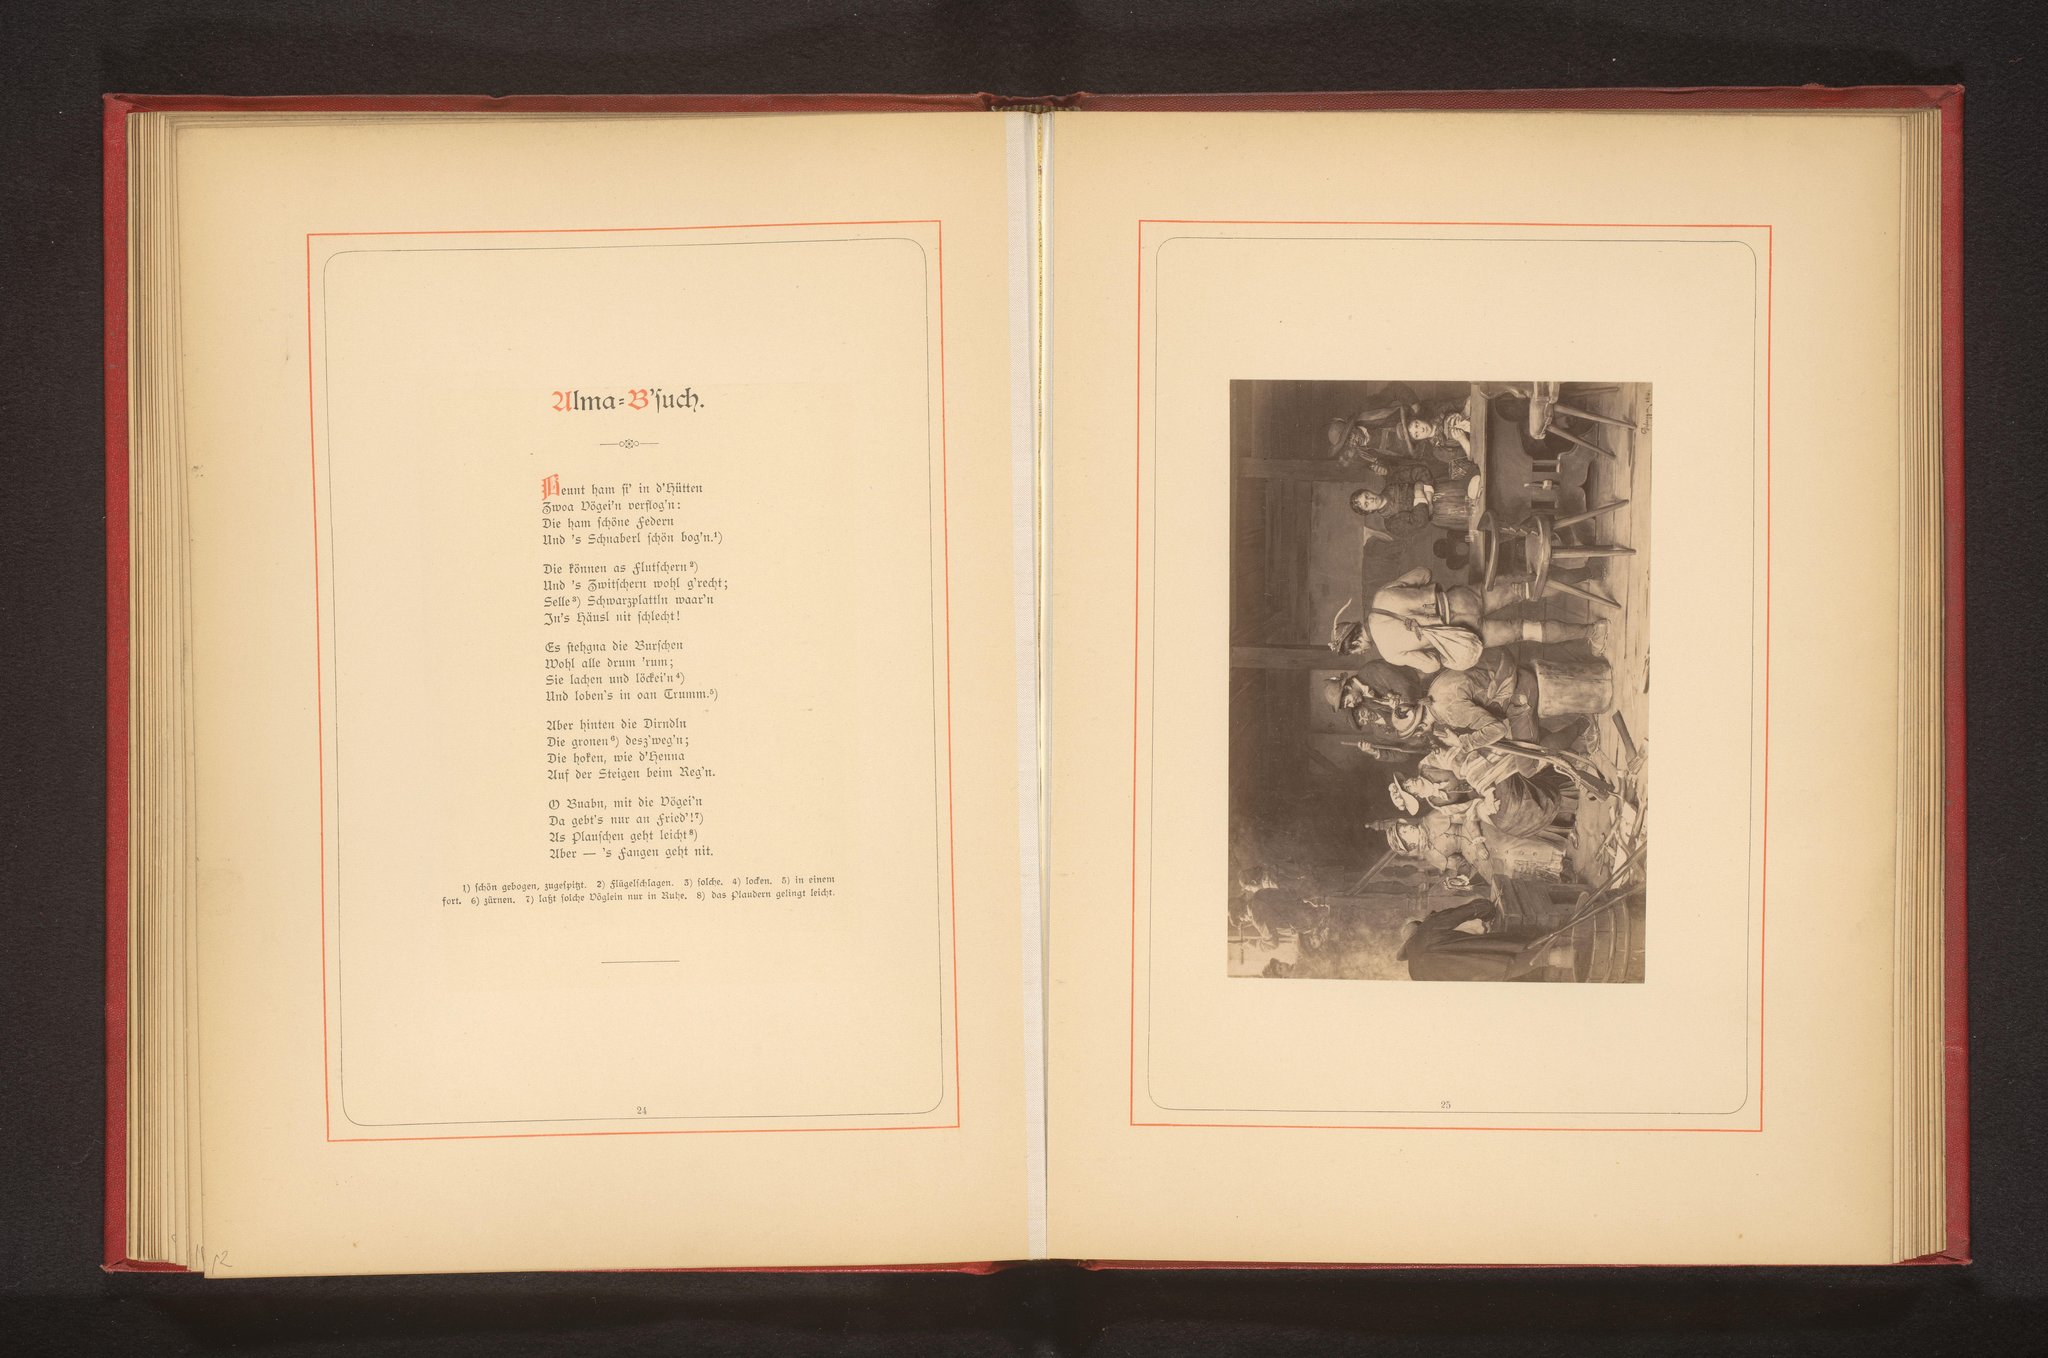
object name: photograph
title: Fotoreproductie van een schilderij, voorstellende een gezelschap met jachtgeweren in een interieur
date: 1881-1883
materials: photographic support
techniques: albumen print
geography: germany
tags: firearms: rifle, interior ~ representation of a building